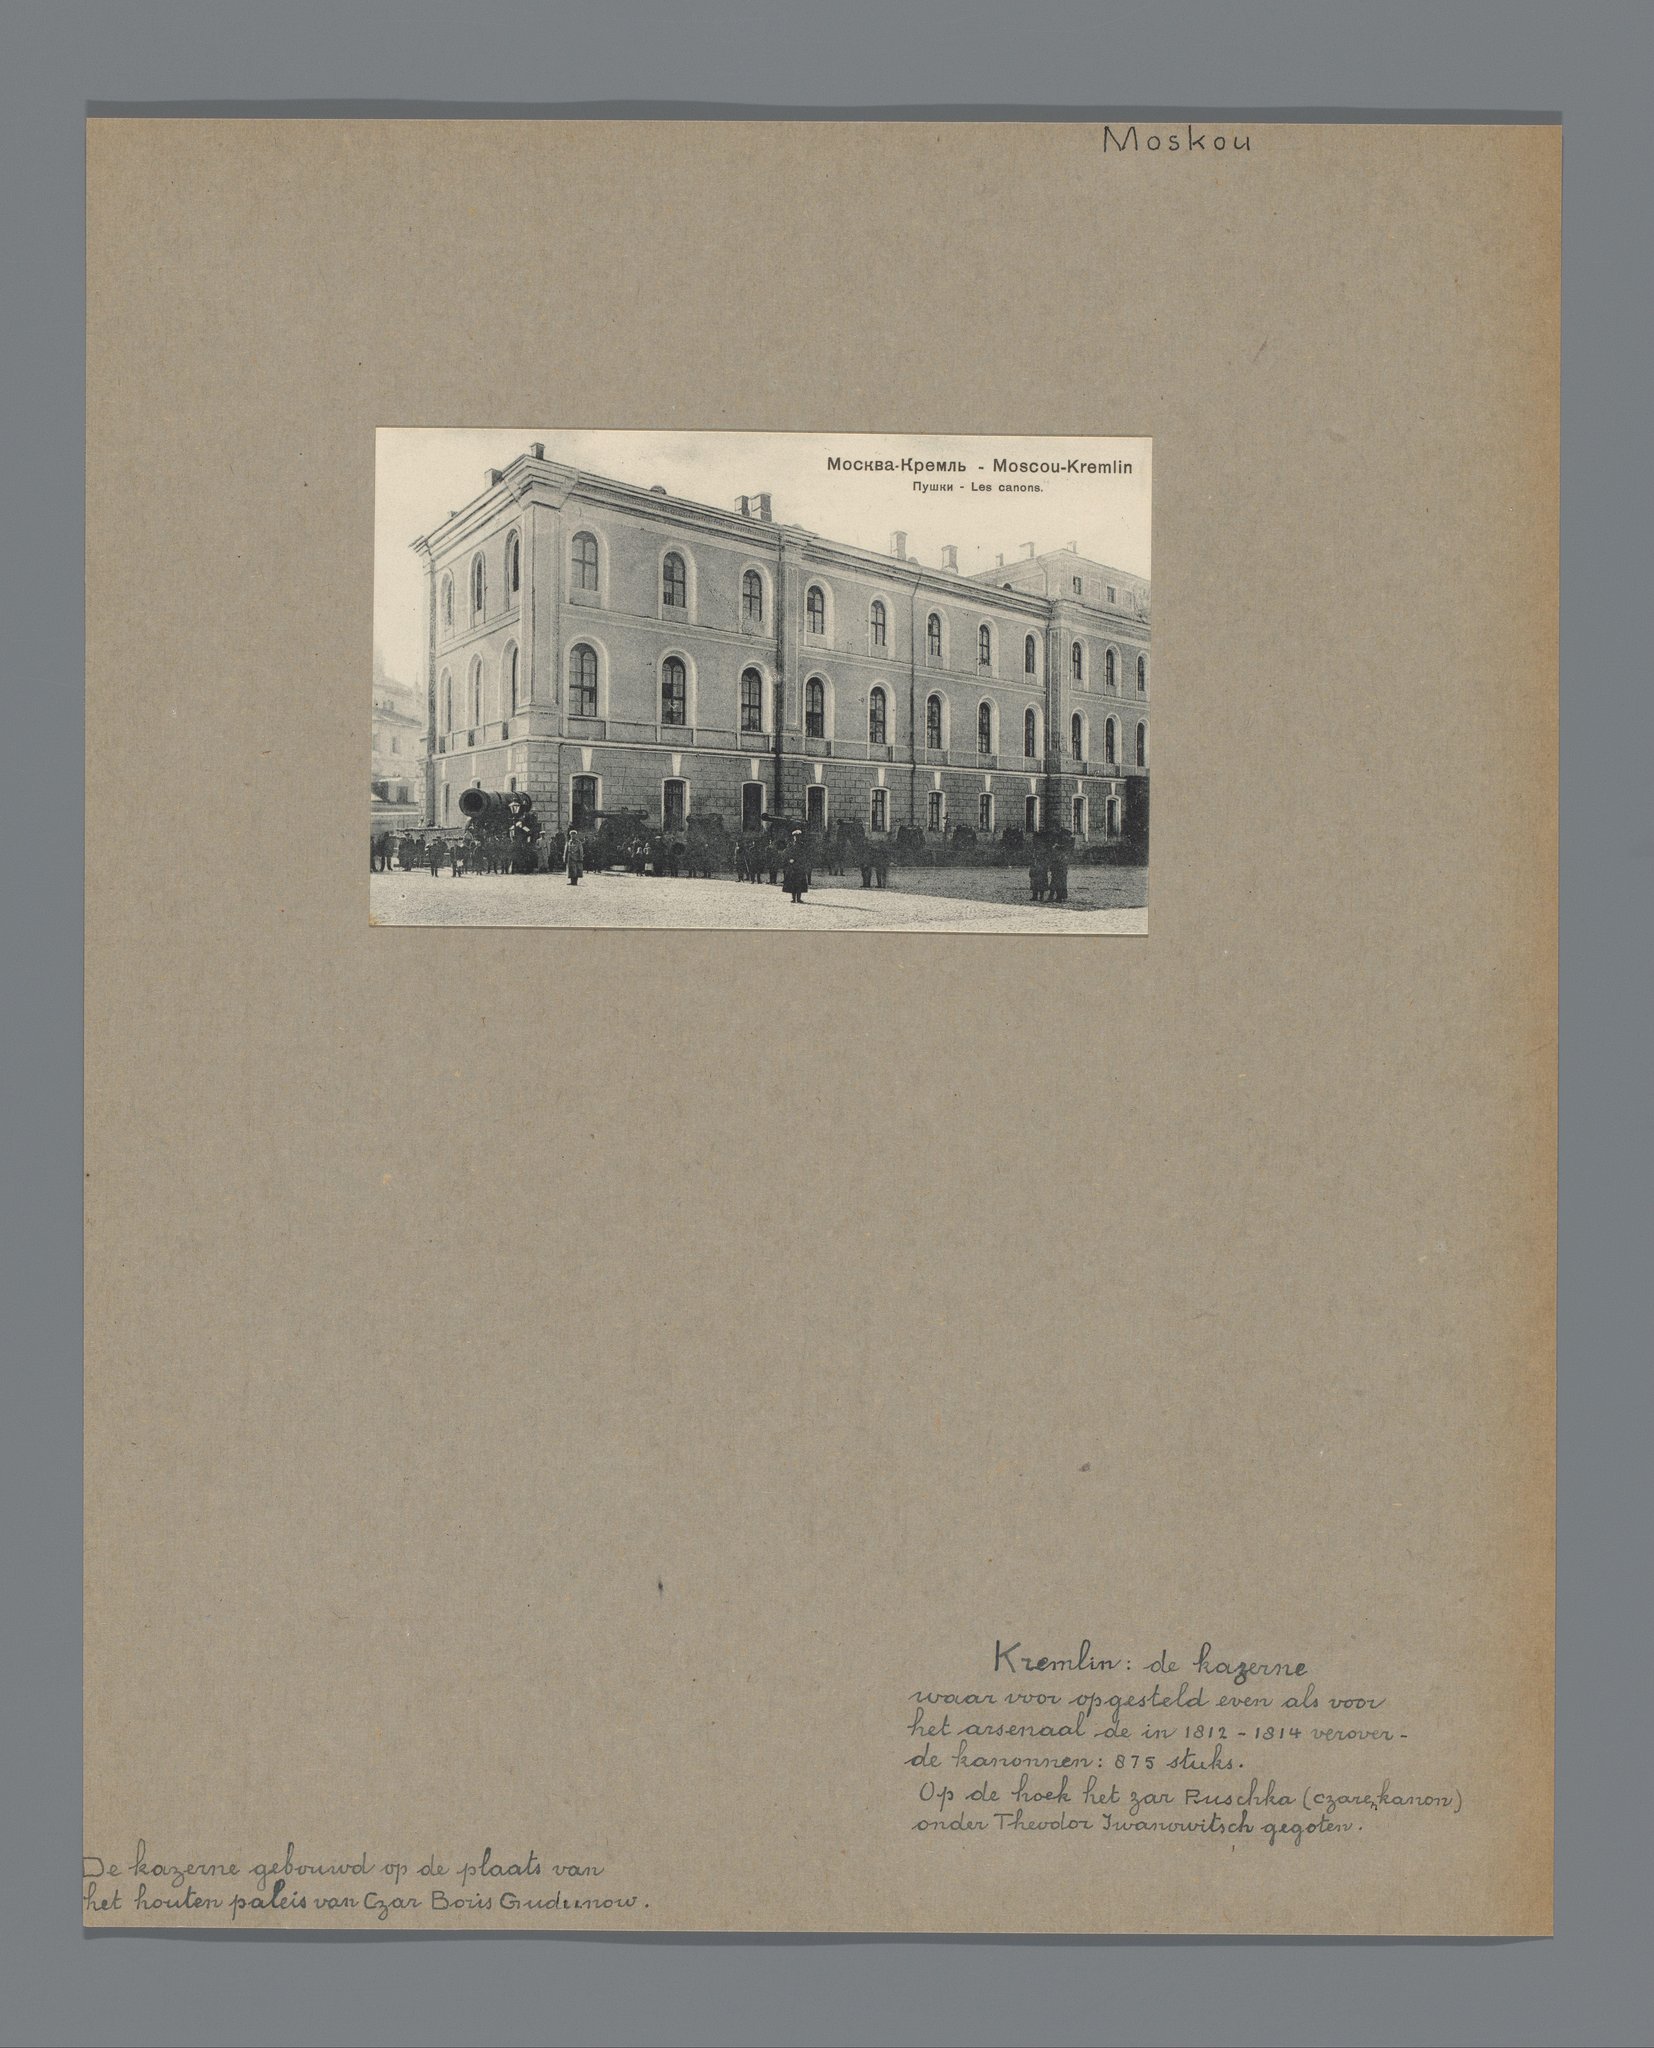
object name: photograph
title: Kremlin: de kanonnen. Moskou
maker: Anonymous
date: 1860-1925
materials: photographic support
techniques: photograph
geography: russia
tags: moskou